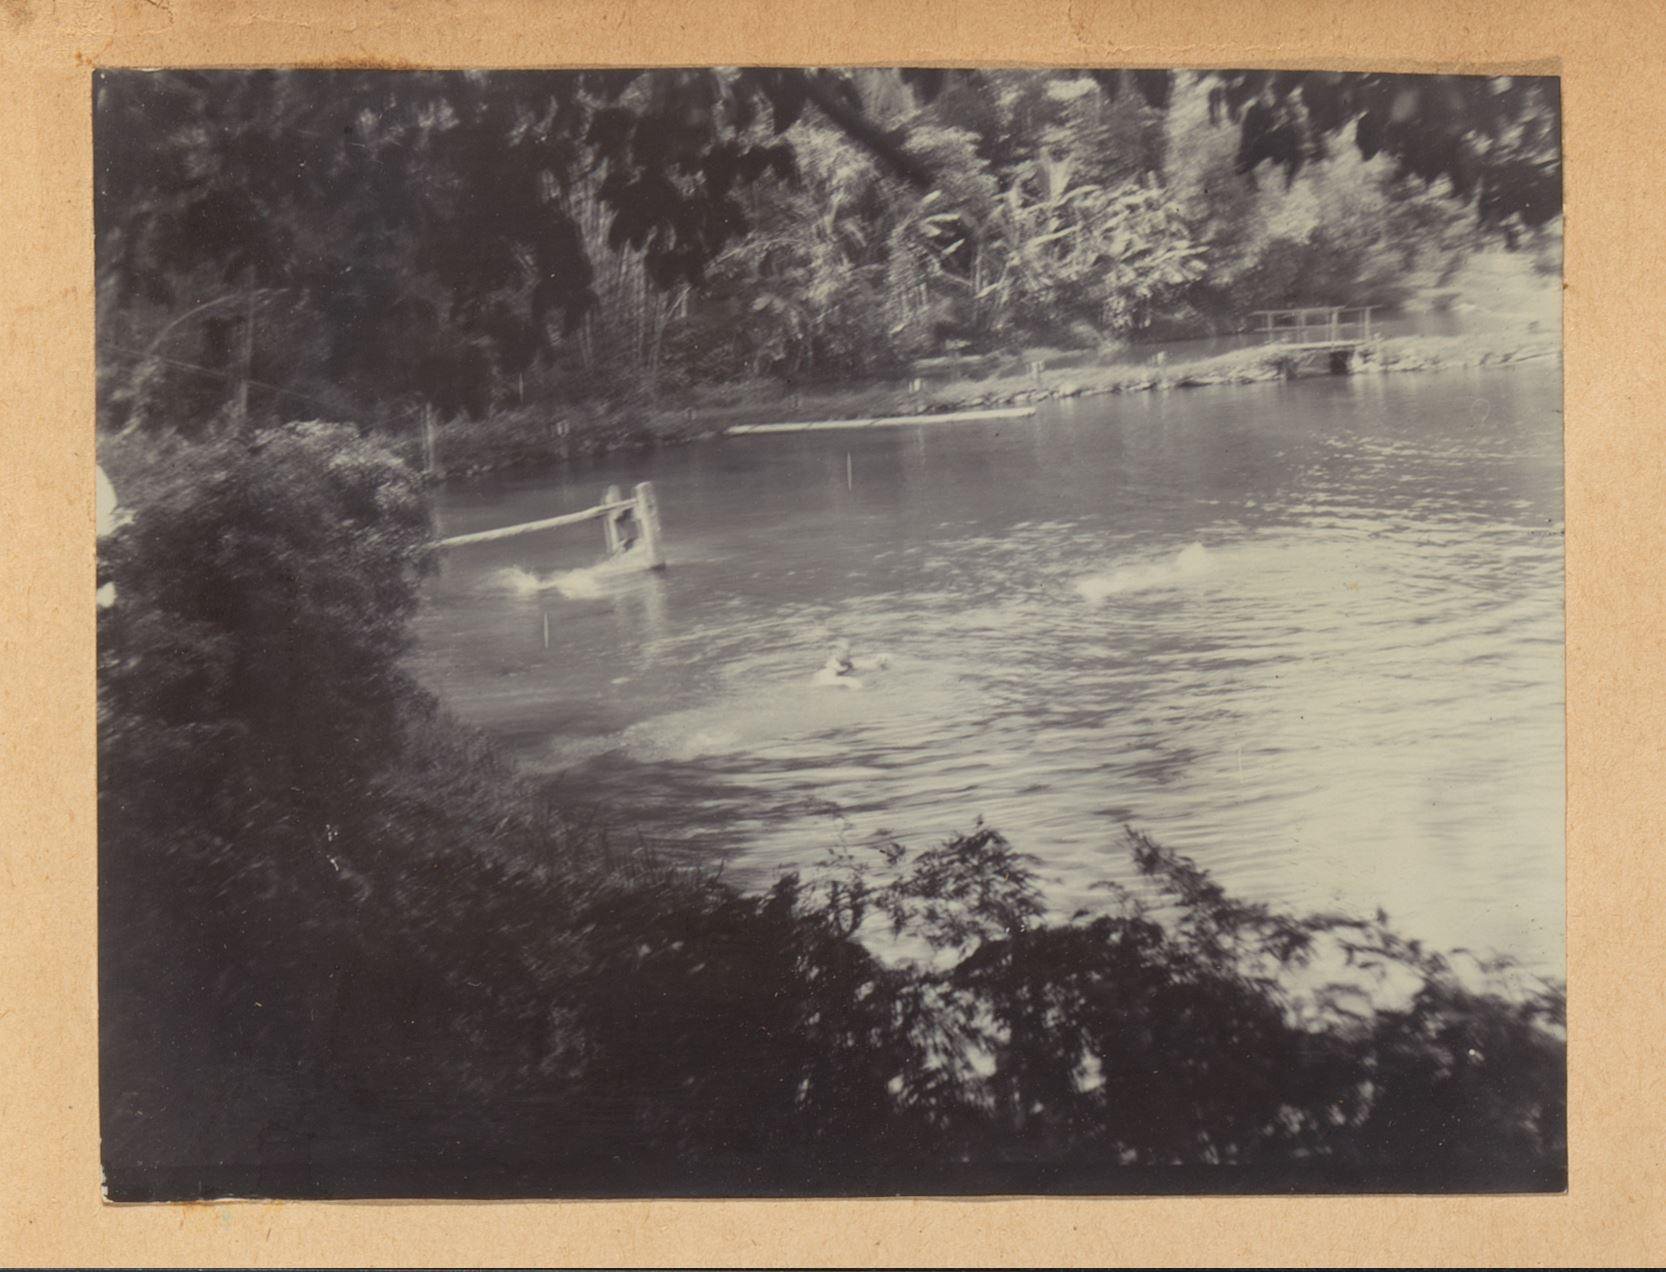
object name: photograph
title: Gezicht op een rivier met zwemmers in Nederlands-Indië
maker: Anonymous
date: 1917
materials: photographic support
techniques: gelatin silver print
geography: dutch east indies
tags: river (+ landscape with figures, staffage), dutch east indies, the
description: Onderdeel van Familiealbum met foto's van een familie in de voormalige kolonie Nederlands-Indië en van een suikerfabriek in Purworejo.